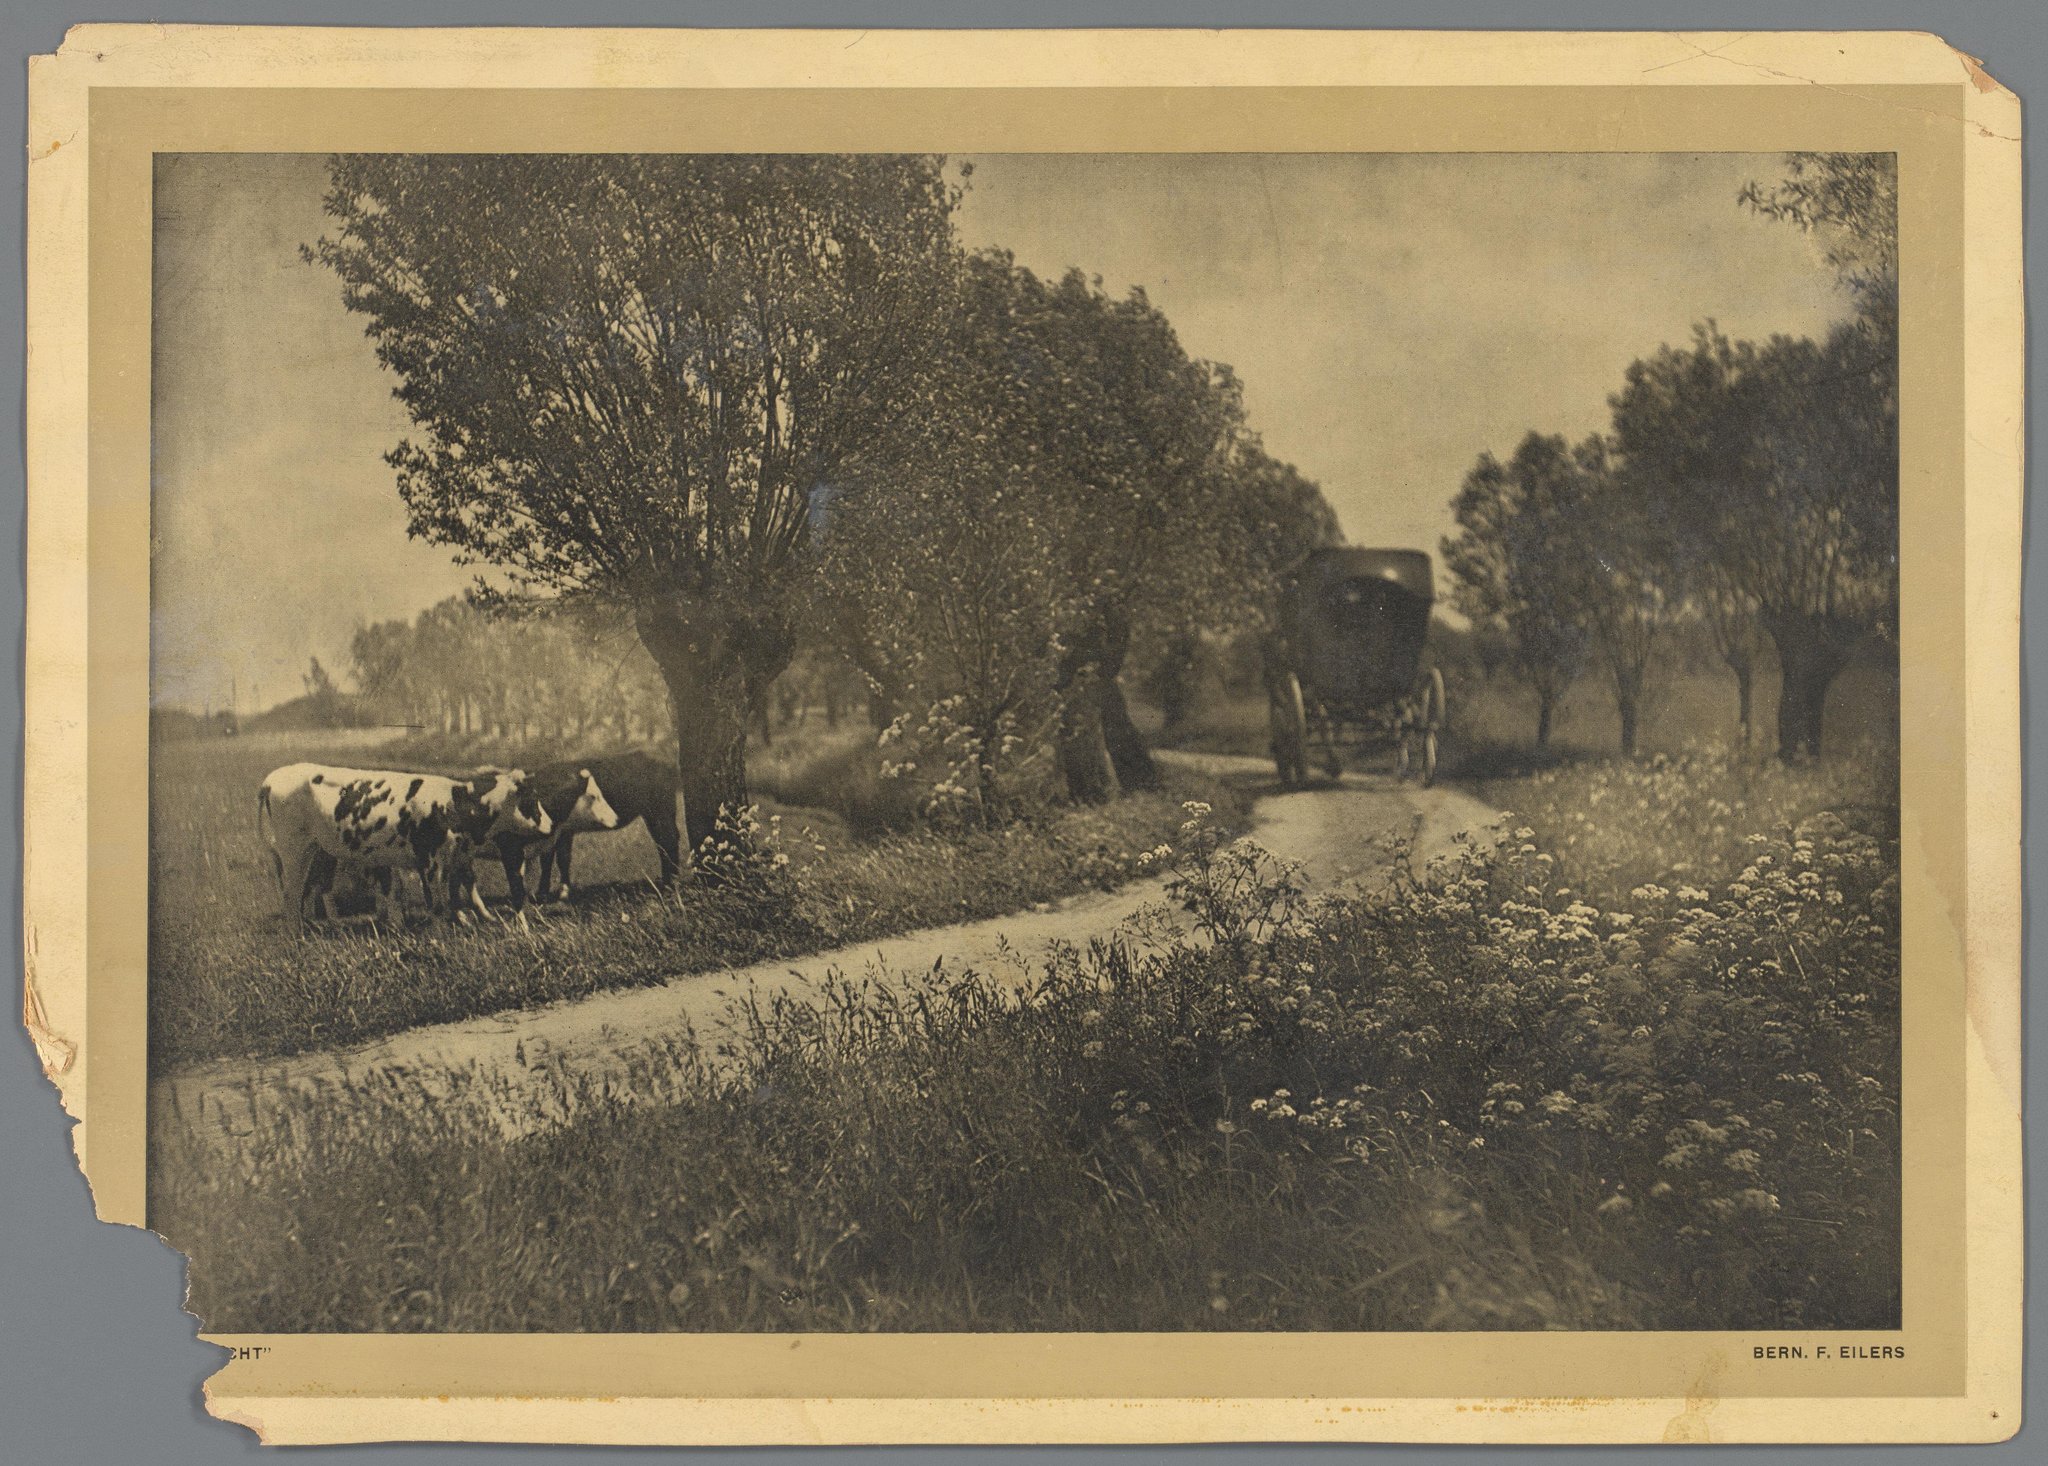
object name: photomechanical print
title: Rijtuig over landweg naast een weiland met koeien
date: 1891-1951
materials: paper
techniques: autotype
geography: netherlands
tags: four-wheeled vehicle drawn by one animal, cow, netherlands